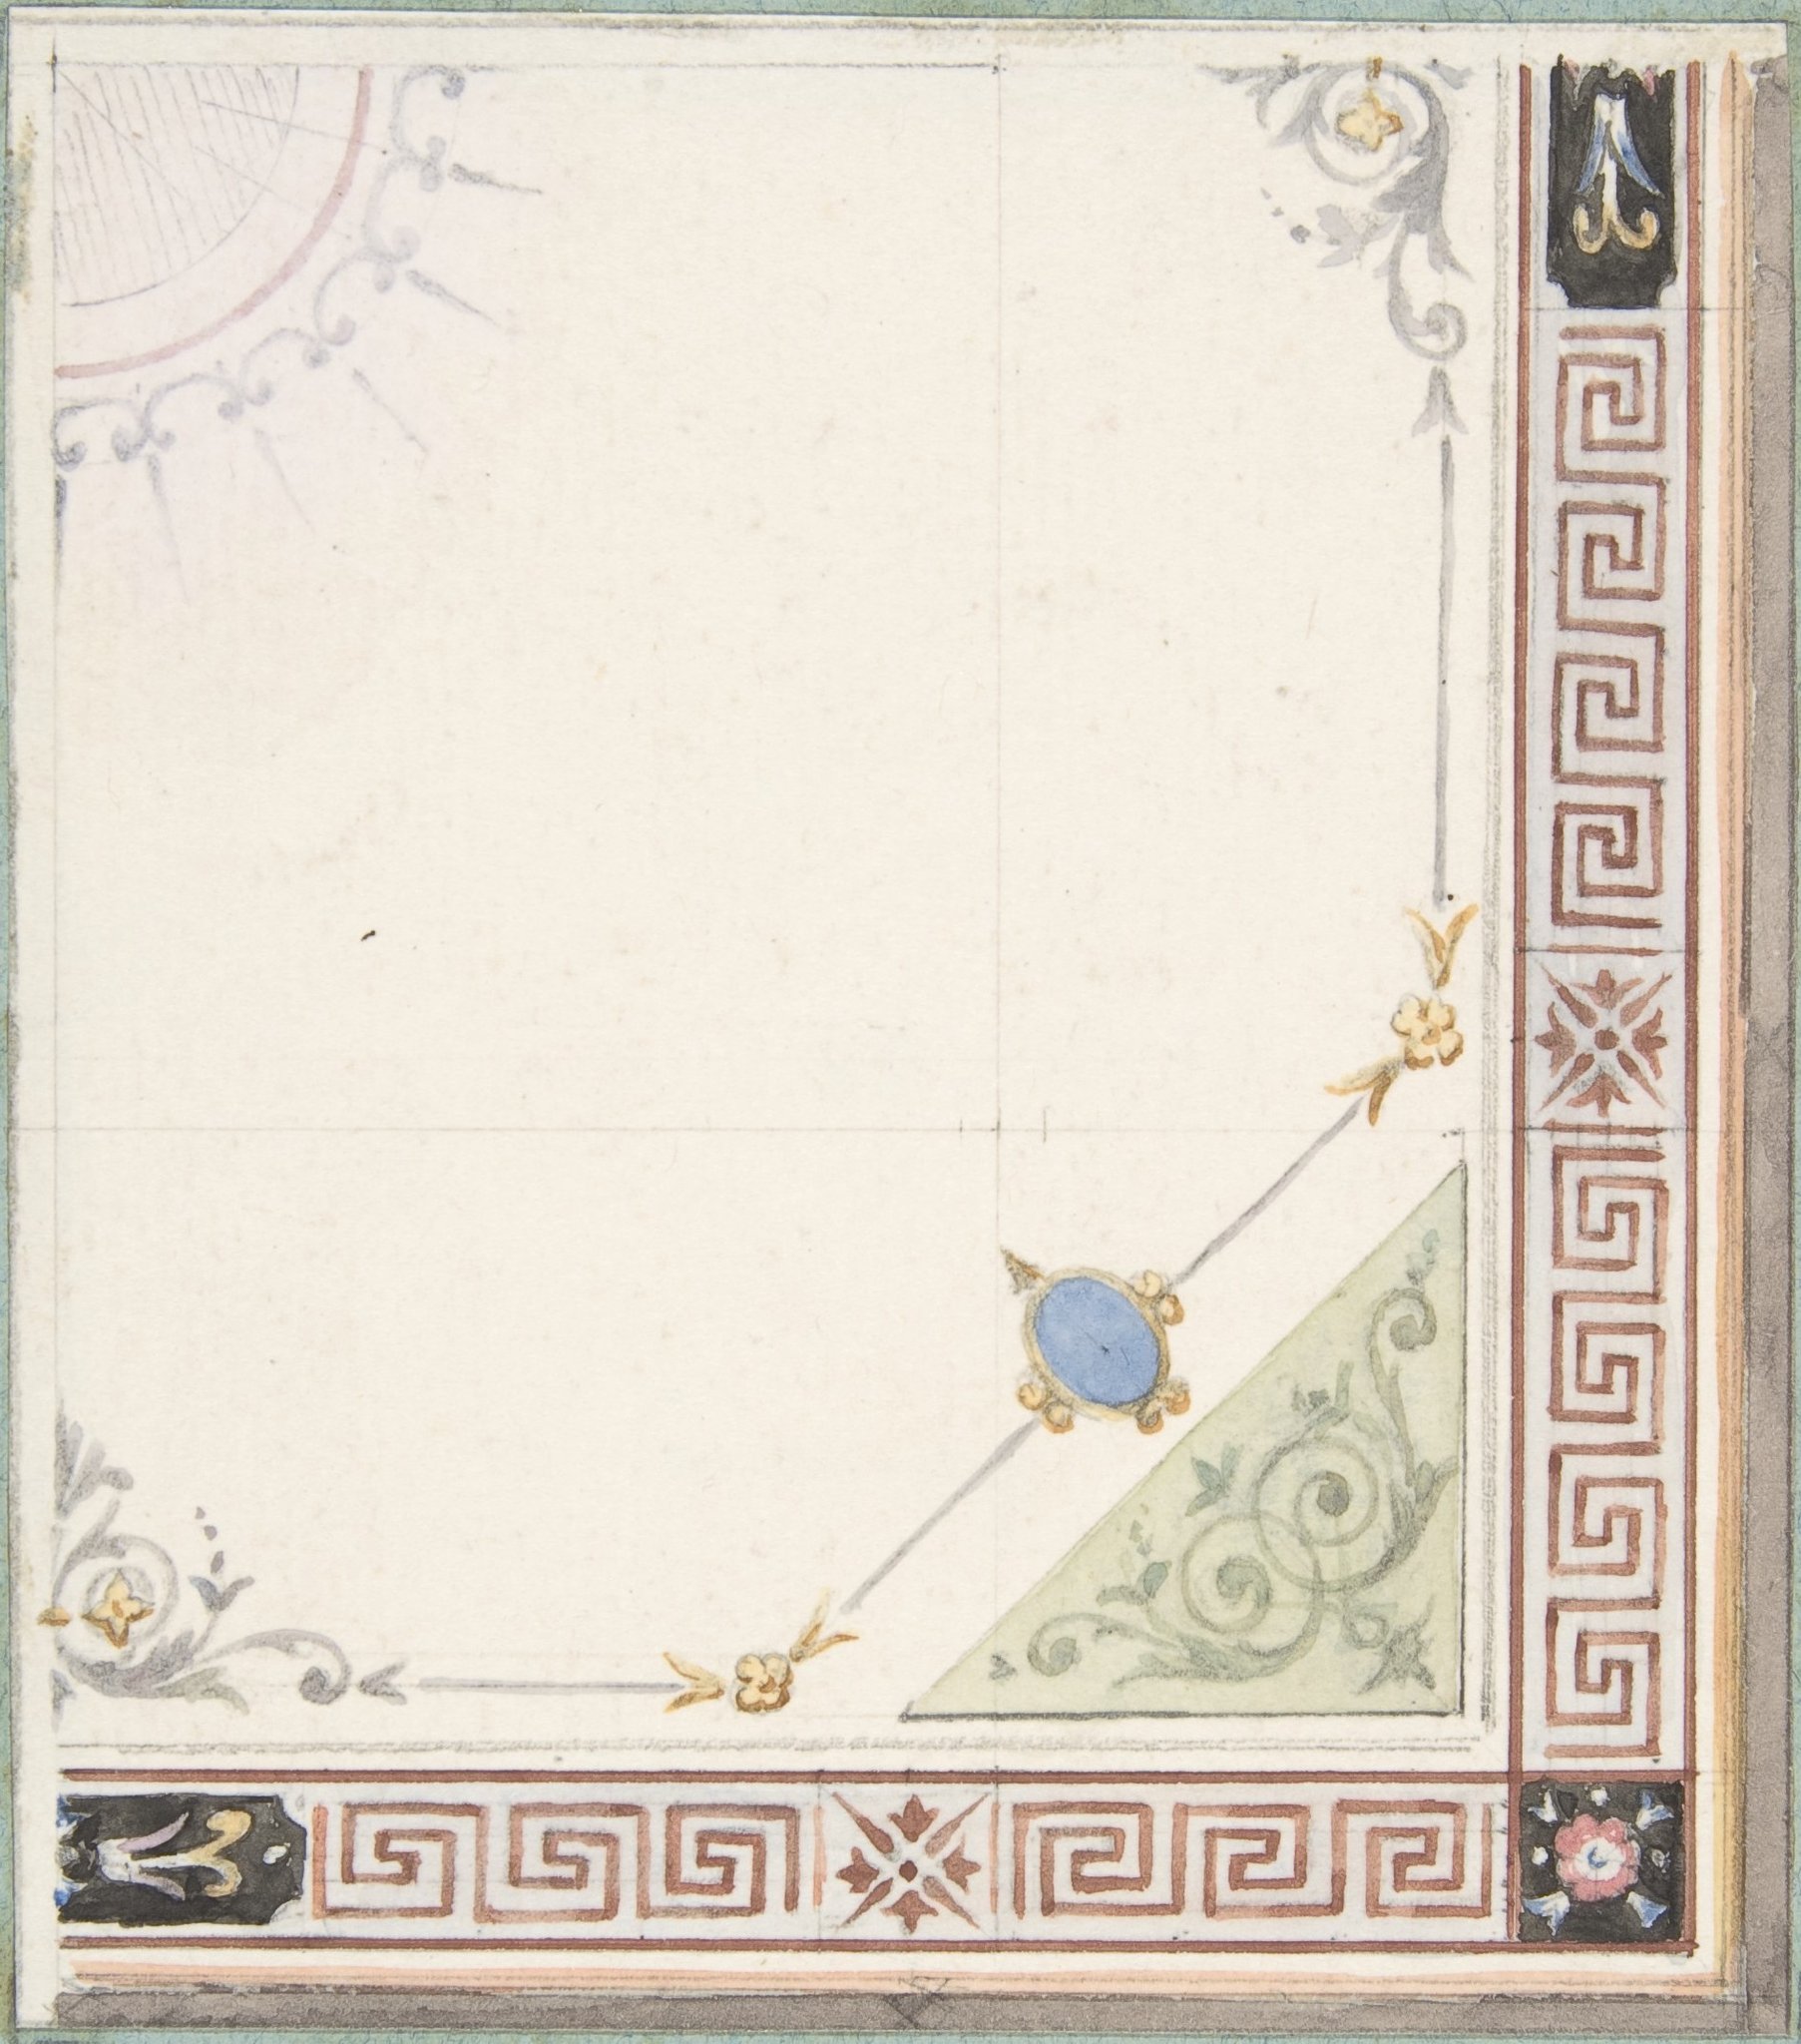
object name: drawing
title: Pompeiian Design for Paneling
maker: jules-edmond-charles lachaise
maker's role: artist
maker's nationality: french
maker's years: 1897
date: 1851-1900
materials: graphite, watercolor